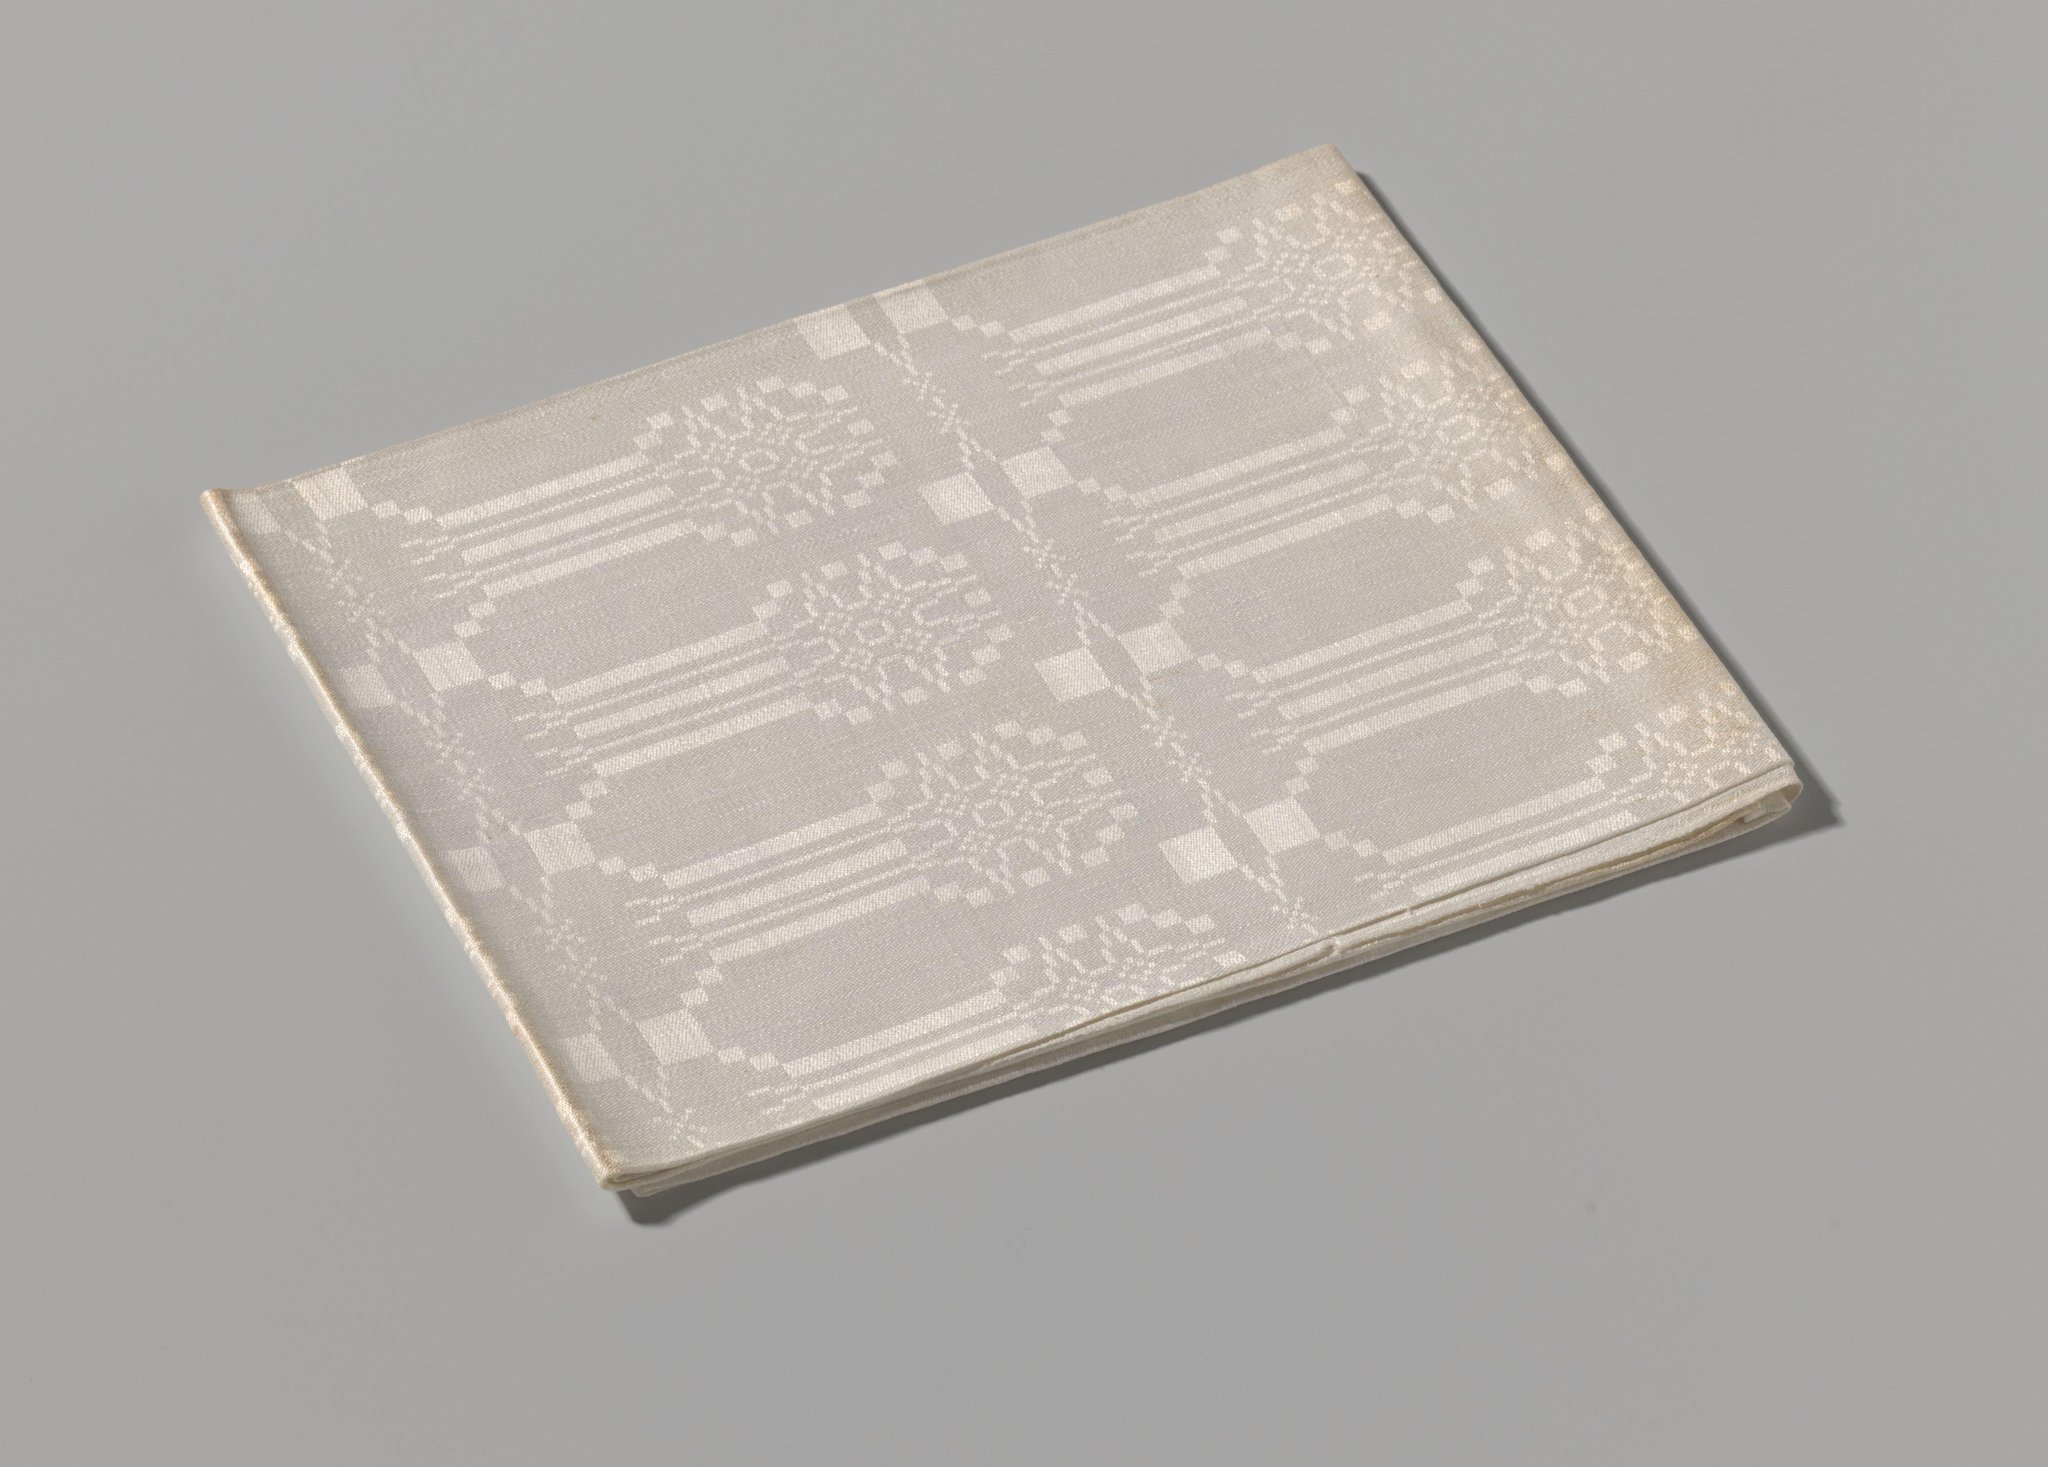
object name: napkin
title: Servet van linnen met pellenpatroon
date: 1734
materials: linen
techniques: peeled fabric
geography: northern netherlands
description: Servet van wit linnen met pellenpatroon "oranjeboom", merk WG 60 1734.